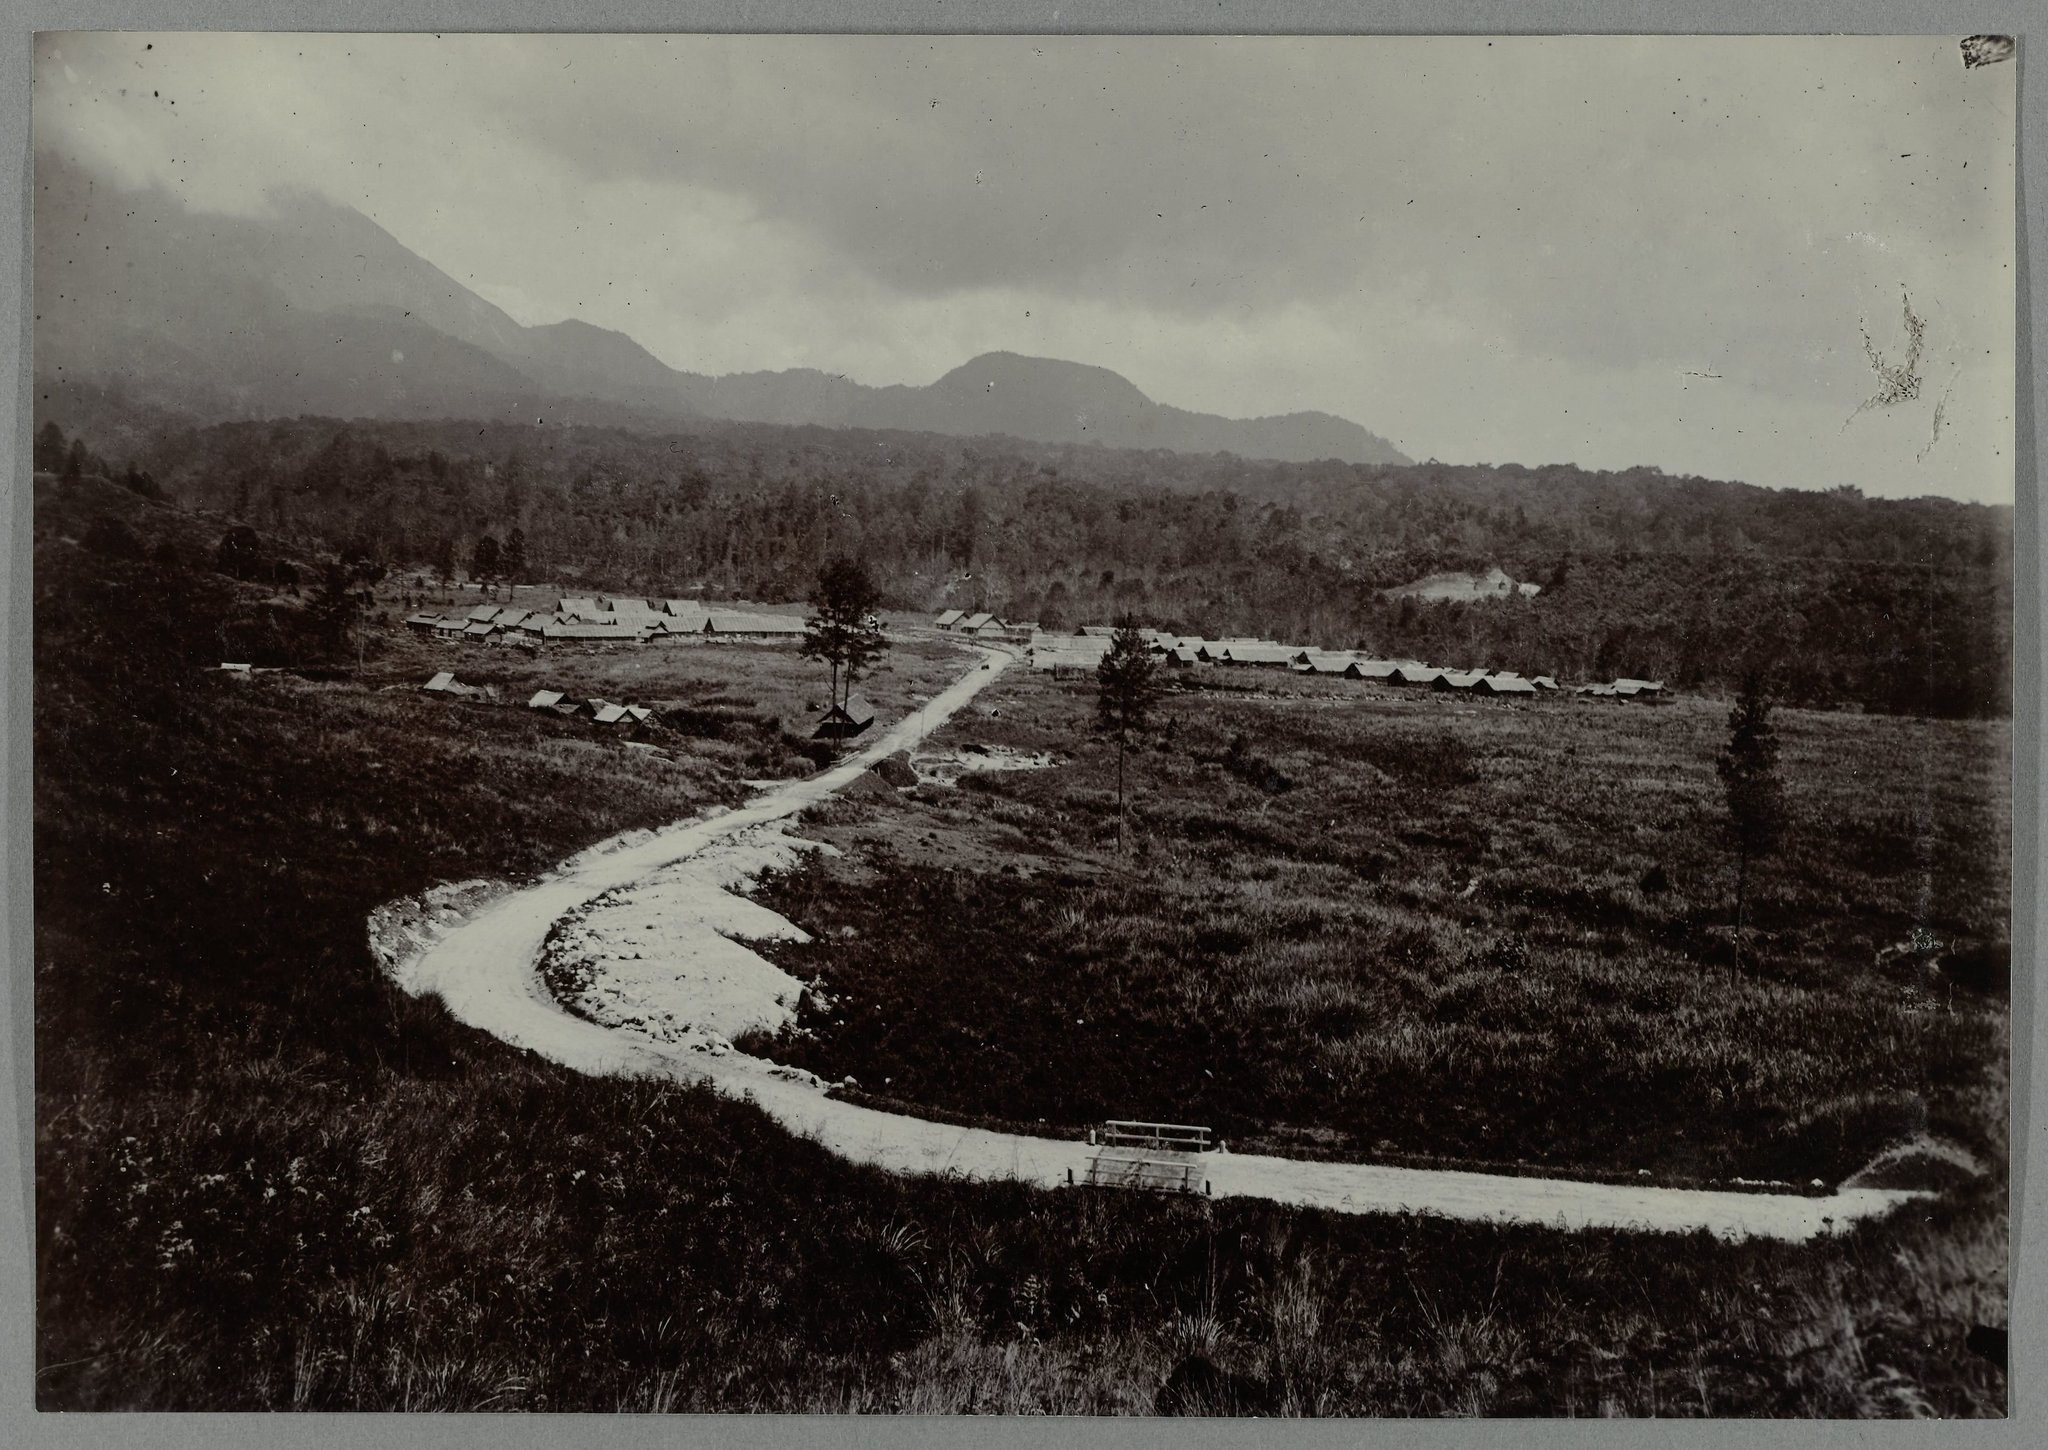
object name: photograph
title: Bivak Lampahan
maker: Anonymous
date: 1903-1913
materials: photographic support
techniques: photography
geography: north sumatra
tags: albertus dominicus laman trip, traffic by road or path with motor-vehicle, landscapes in tropical and sub-tropical regions, village, road, path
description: Na de expedities naar de Gajo- en Alaslanden o.l.v. Van Daalen (eerste tocht in 1901), werd hij in 1903 belast met voorbereiding van permanente vestiging van Nederlands gezag. Aanleg van een weg van de Noordkust naar het binnenland was hierbij van groot belang. Deze zgn. Gajoweg werd aangelegd tussen 1903 en 1914, van Bireuen aan de kust naar Takinguen aan het bergmeer Danau Lauttawar, totale lente 104 km.